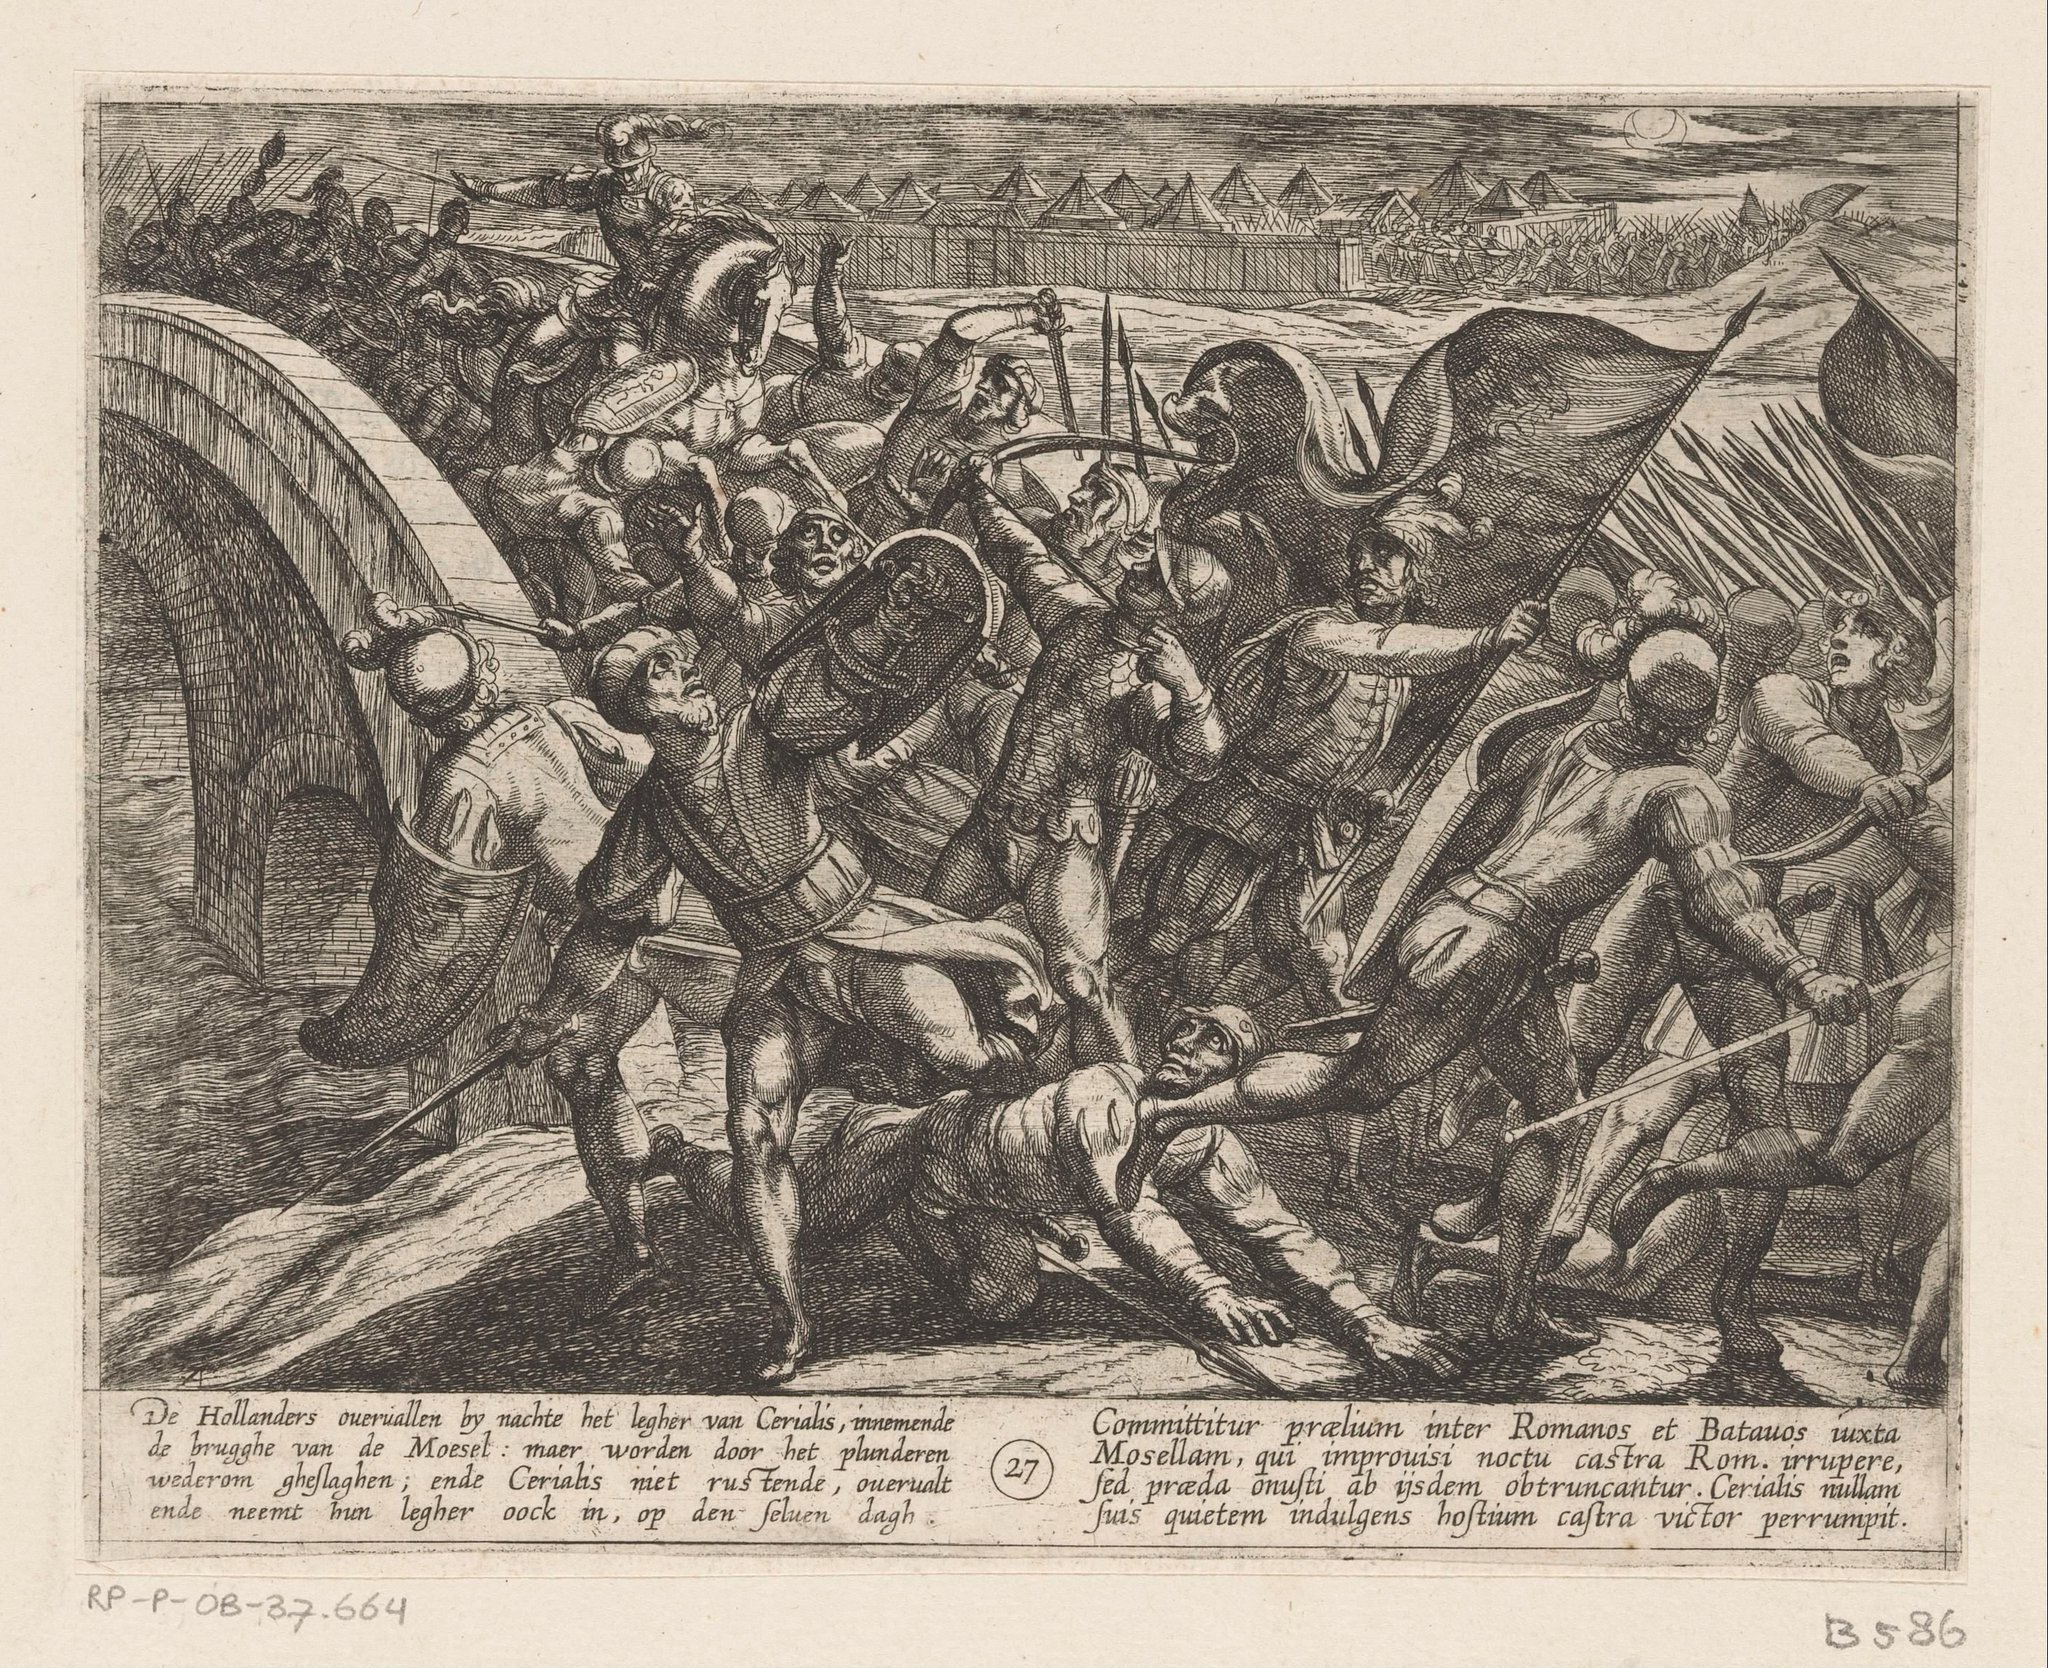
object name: print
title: De Bataafse oorlogen tegen de Romeinen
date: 1611-1612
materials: paper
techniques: etching, letterpress printing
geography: italy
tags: battle, the soldier; the soldier's life, extinct, 'historical' peoples (with name)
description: Nederlandse soldaten plegen een verrassingsaanval op het Romeinse kamp aan de Moezel. Onderschrift in het Nederlands en in het Latijn.